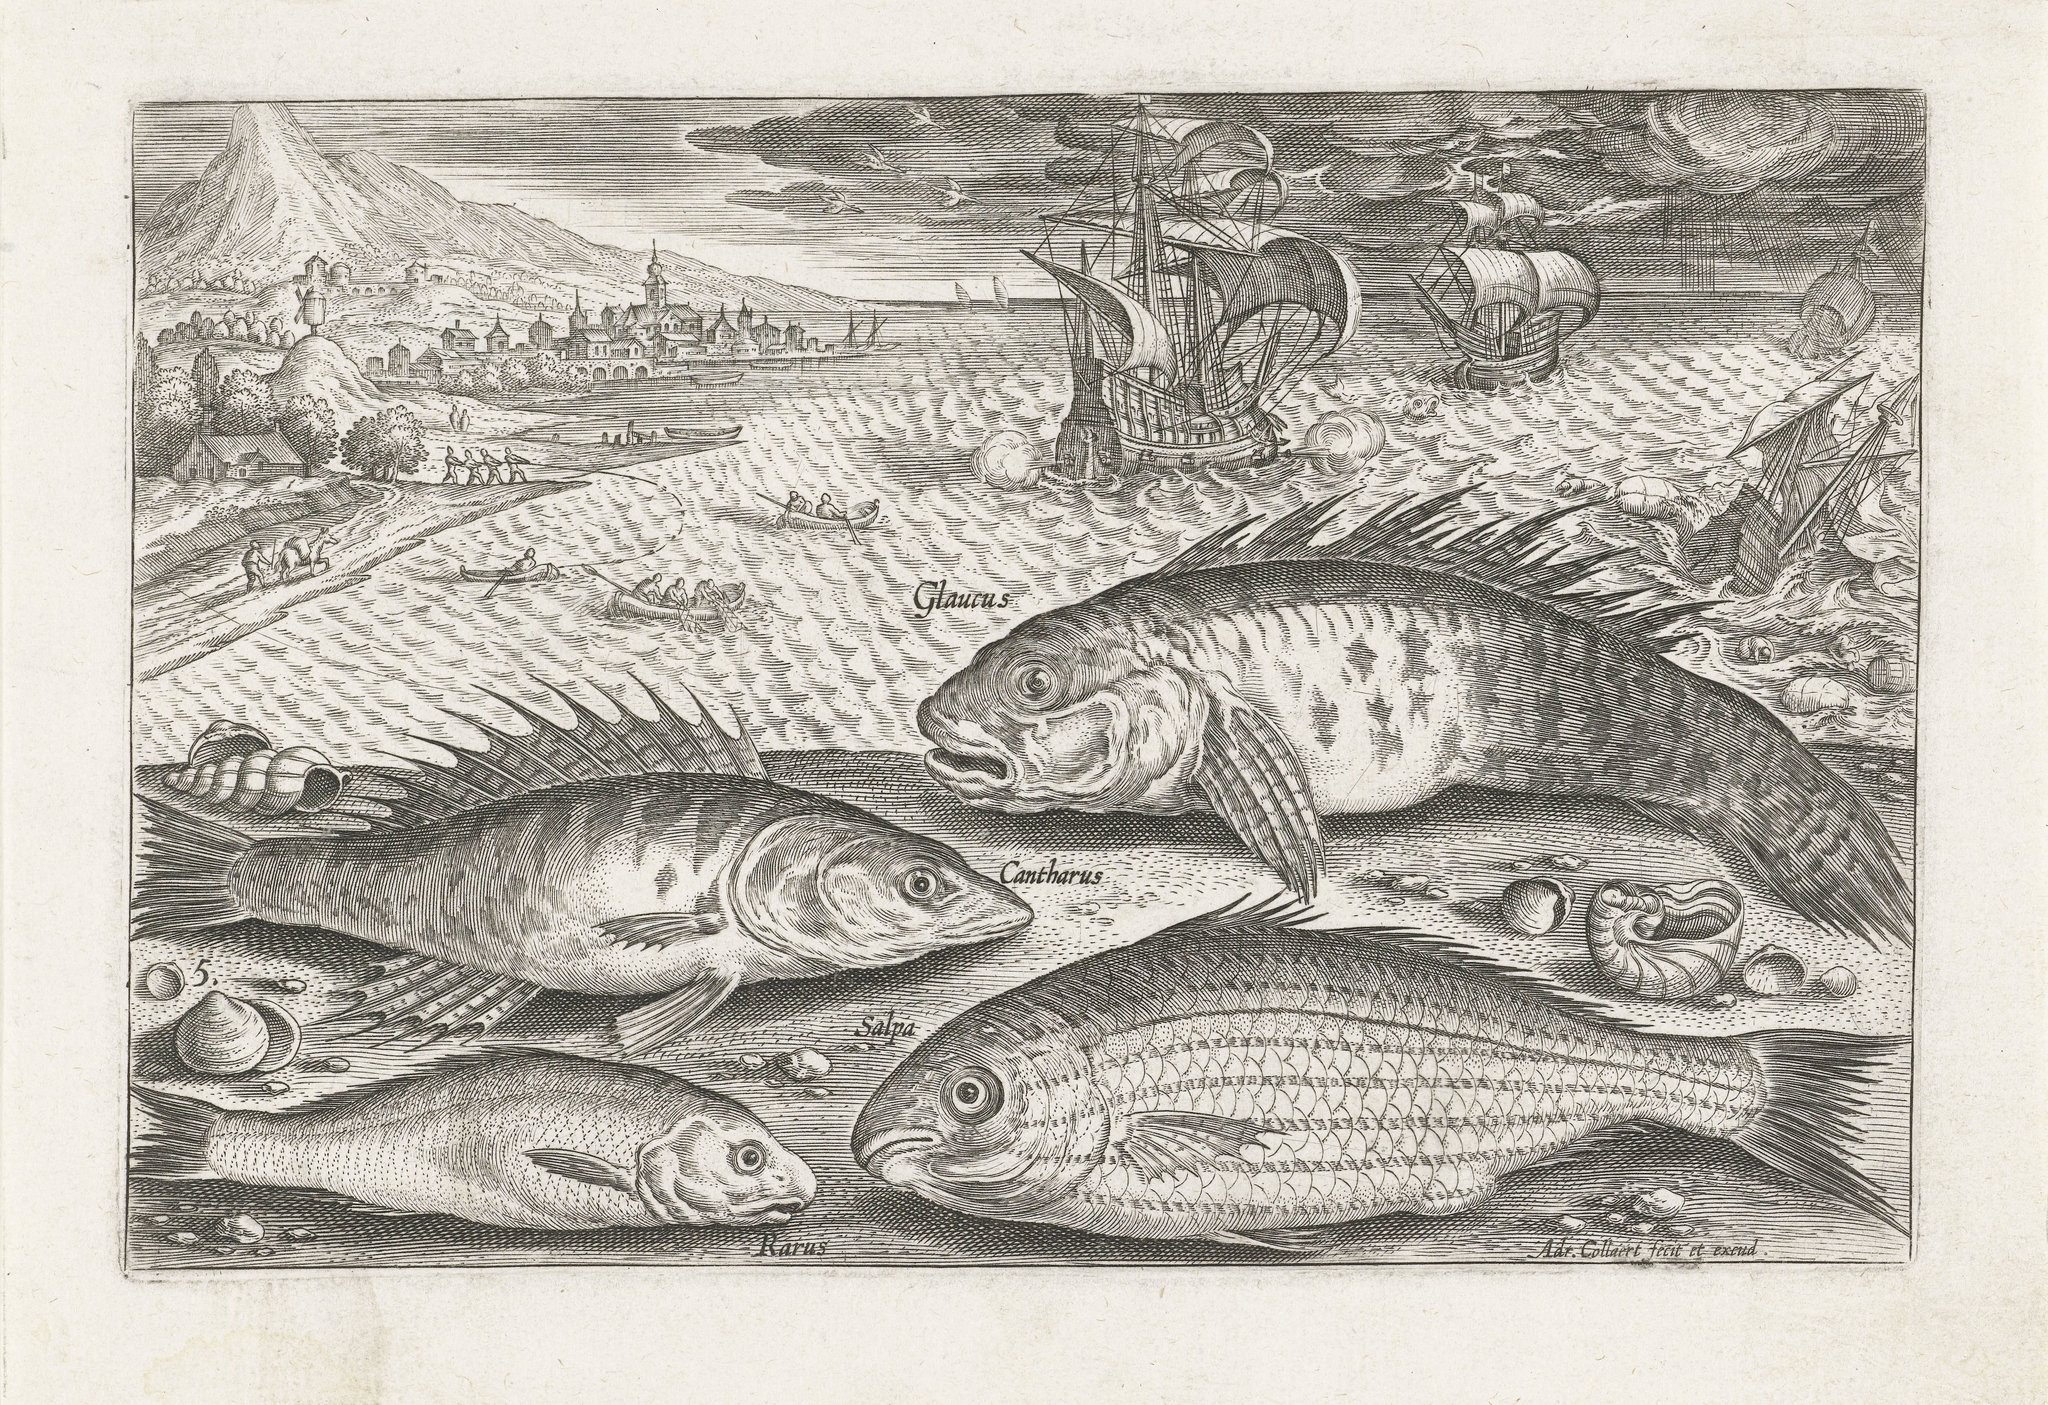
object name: print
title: Vissen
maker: adriaen collaert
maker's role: draughtsman, print maker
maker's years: 1560-1618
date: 1598-1618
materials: paper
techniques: engraving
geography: antwerp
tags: sea (seascape), bony fishes: sea-bream, bony fishes: salpa, bony fishes: goby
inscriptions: collector's mark: Lugt 2228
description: Een bokvis, een baars, een grondel en een onbekende vis liggen samen met wat schelpen aangespoeld op het strand. Op de achtergrond de zee met wat schepen. De prent maakt deel uit van een serie met vissen als onderwerp.